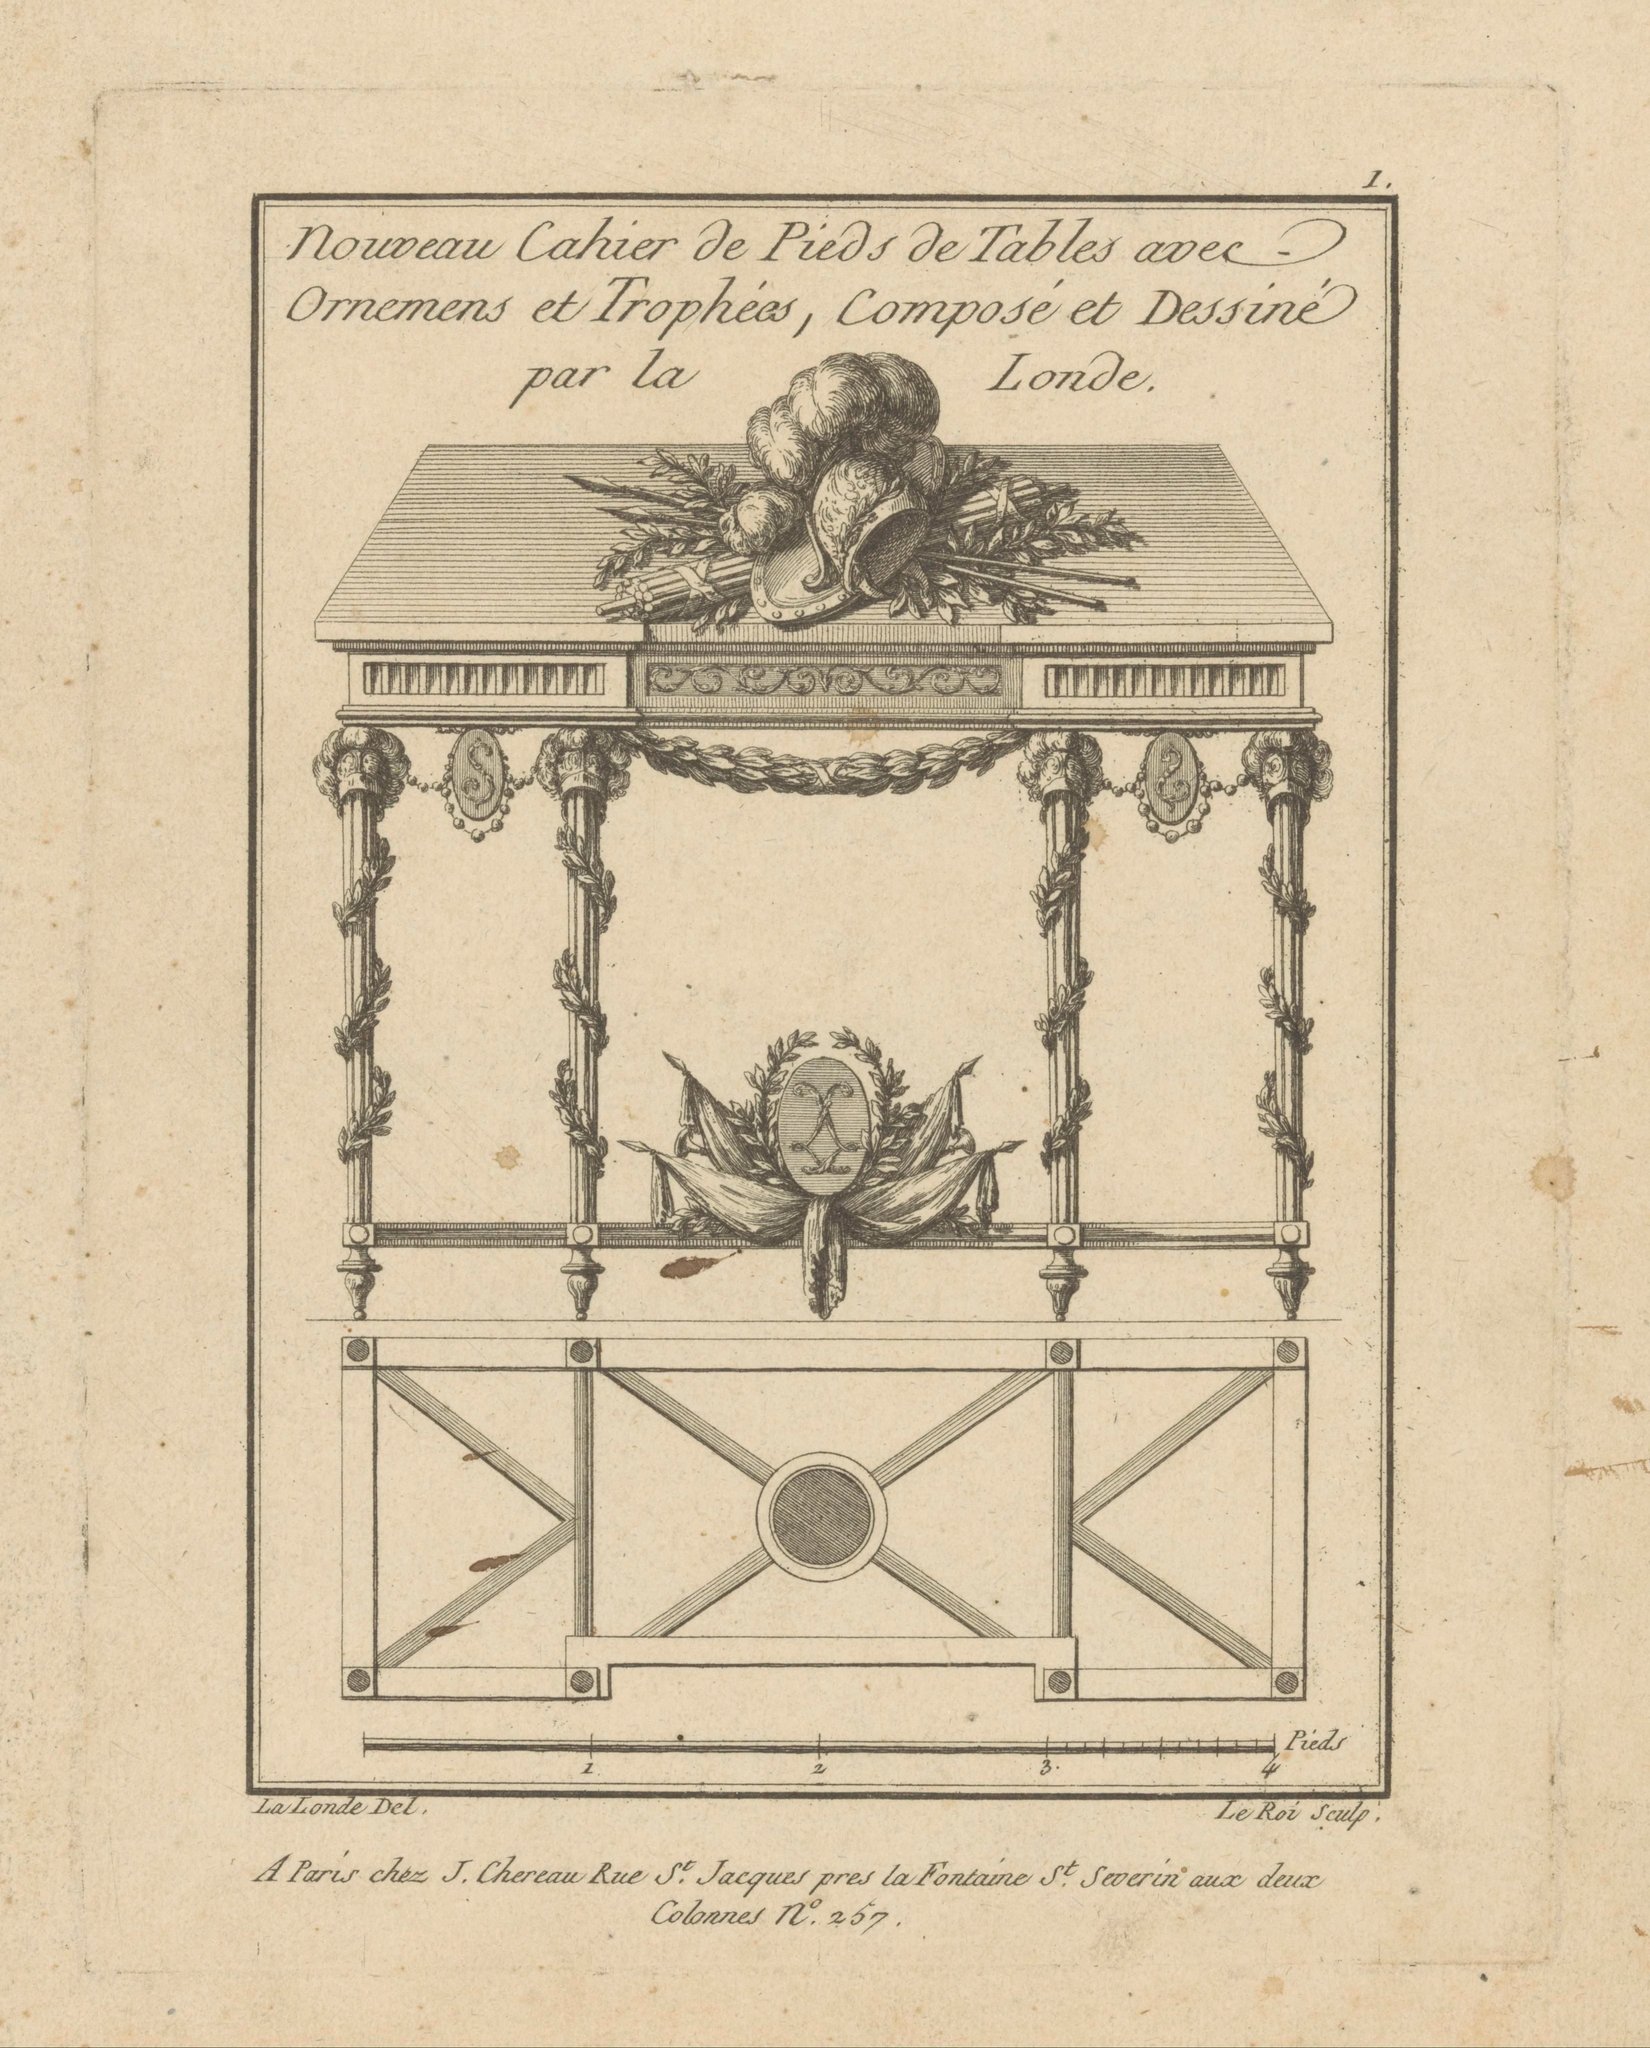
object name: ornament print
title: Tafel met helm en wapens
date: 1784-1785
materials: paper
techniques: engraving, etching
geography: paris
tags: helmet, weapons, table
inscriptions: collector's mark: Lugt 2760, collector's mark: Lugt 2228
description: Voor- en bovenaanzicht van een rechthoekige tafel geornamenteerd met een guirlande, medaillons, ranken en helmen. Aan de onderzijde flankeren vier vlaggen een medaillon met lauwerkrans. Op de tafel liggen een pluimenhelm, een schild, een fases en lansen.